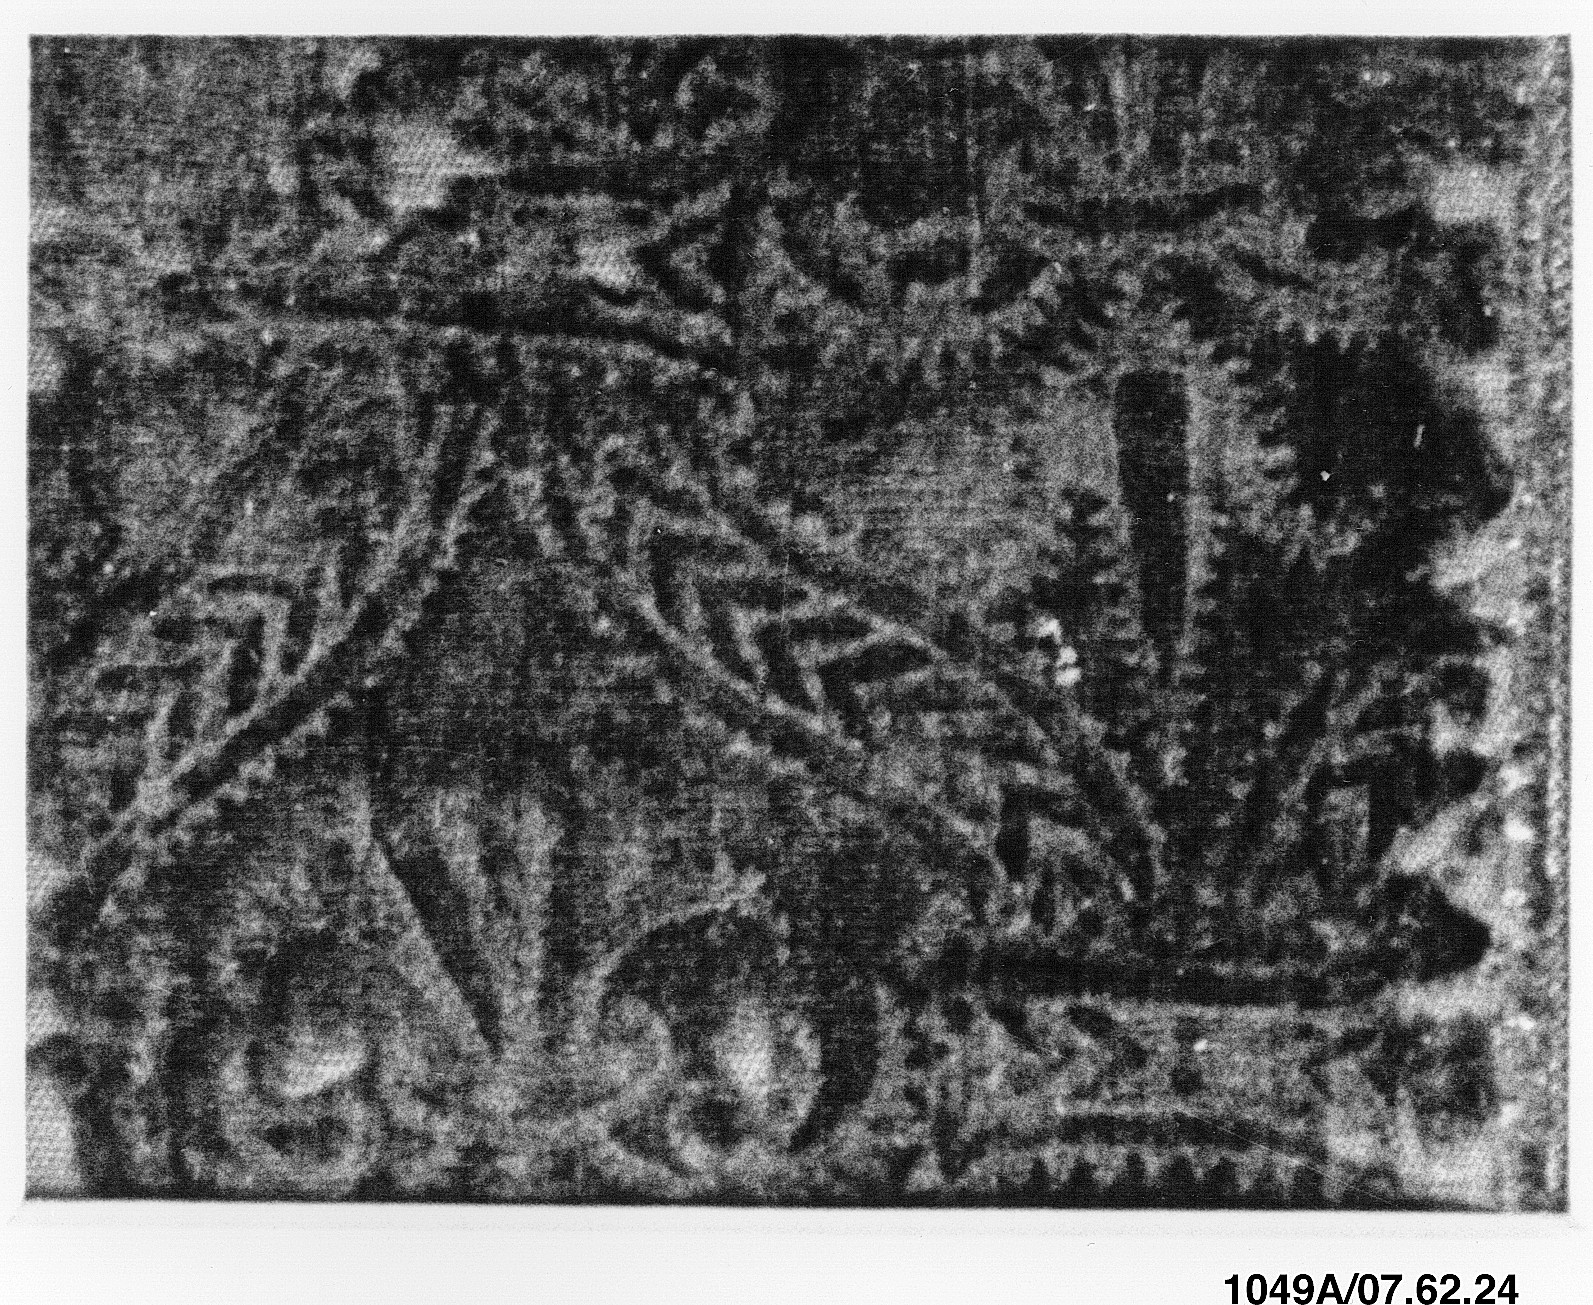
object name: piece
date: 1501-1600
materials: silk